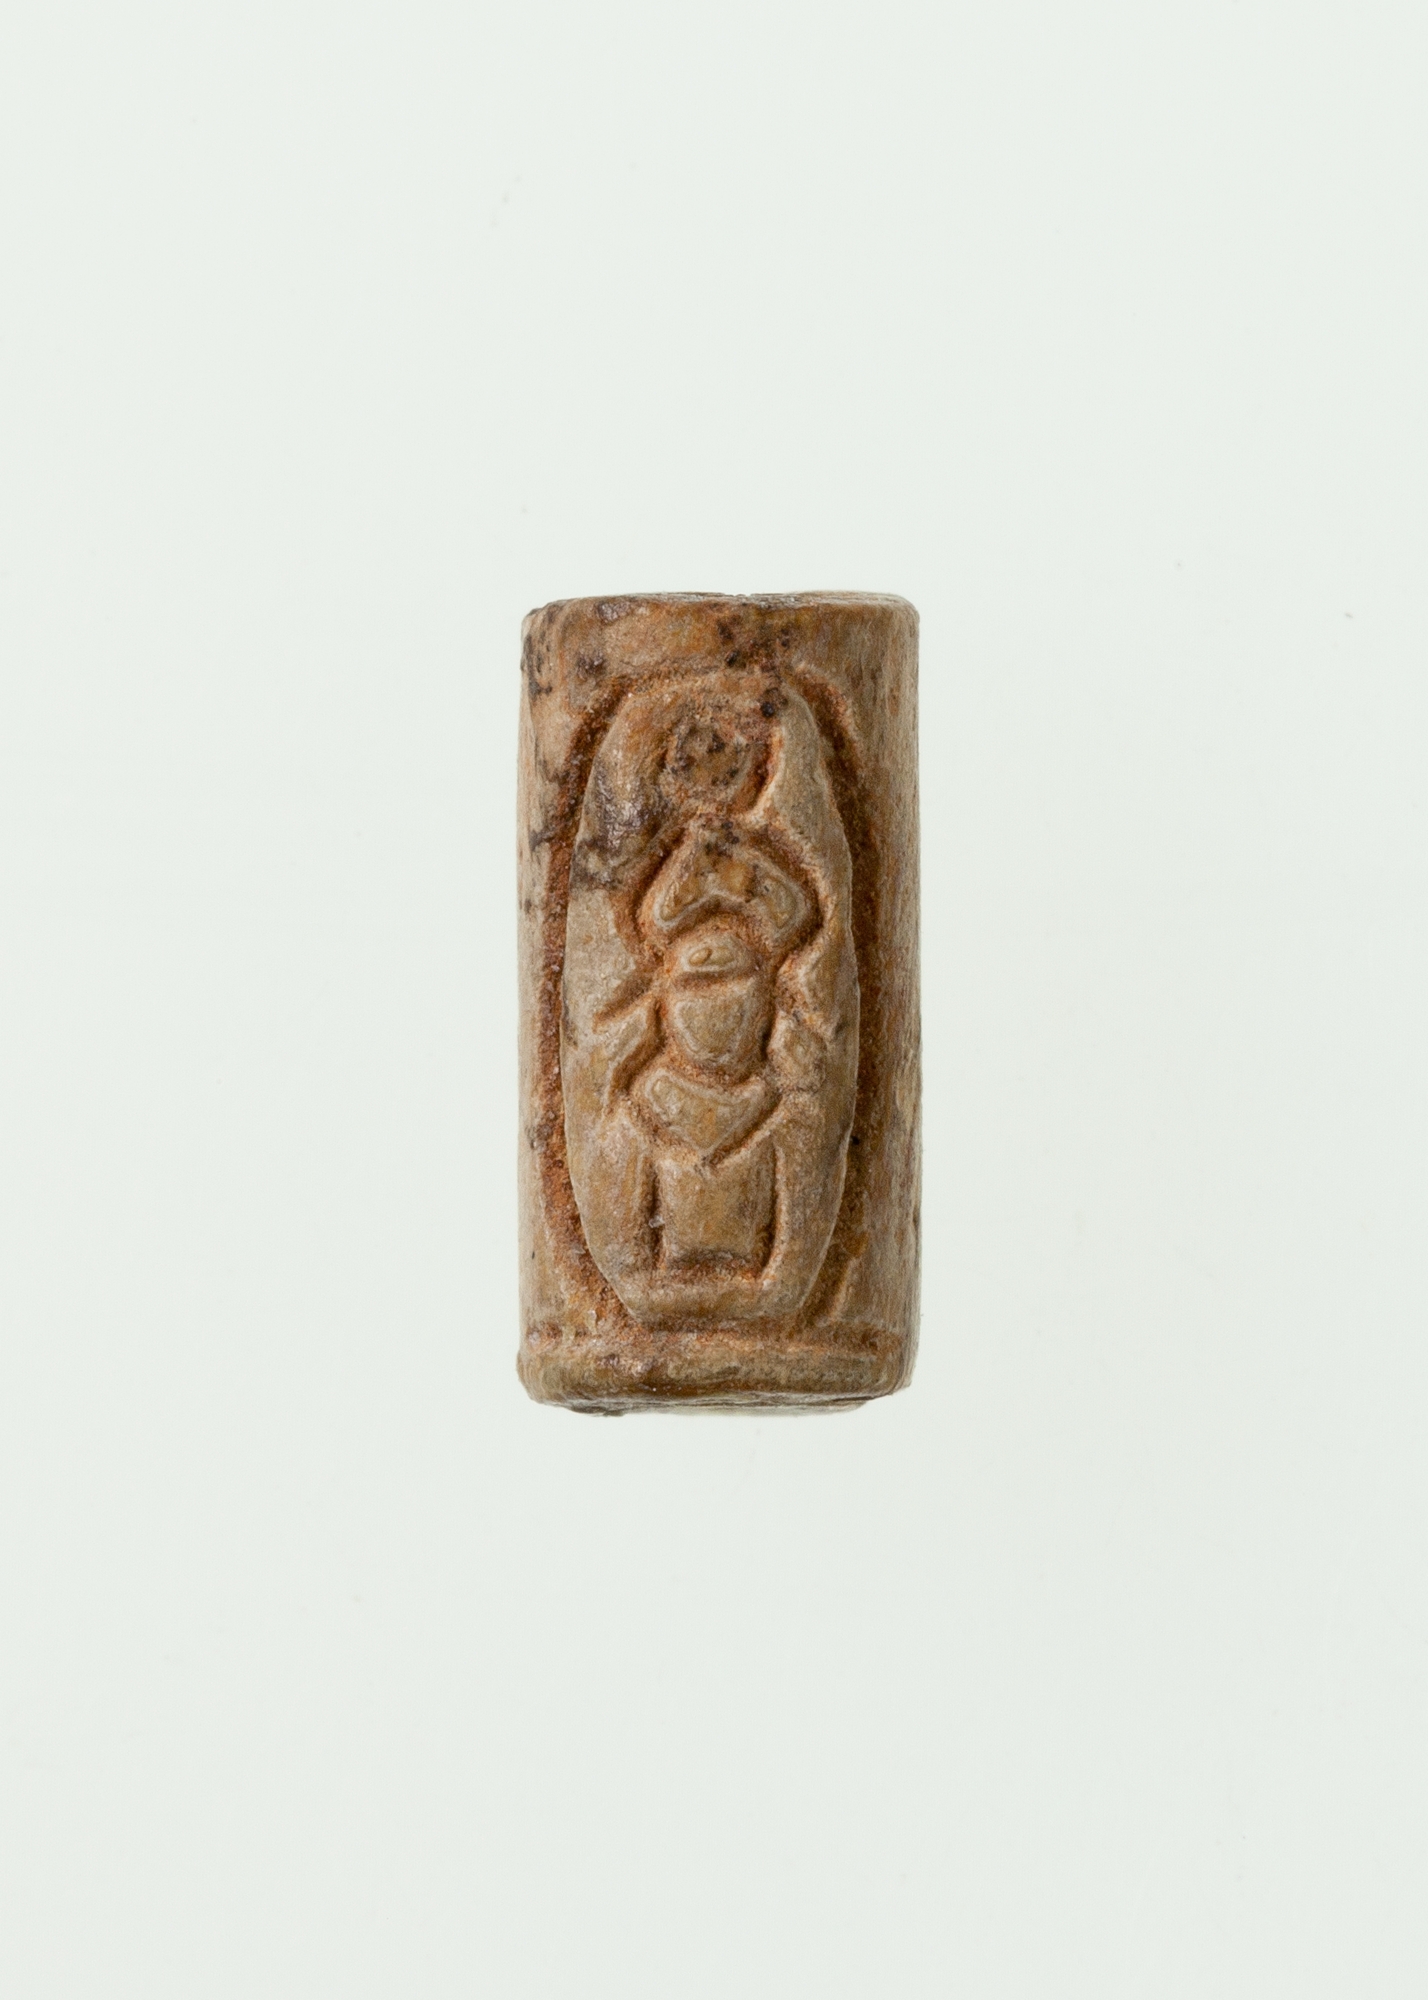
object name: cylinder seal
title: Cylinder seal of Senwosret I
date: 1961-1917 BCE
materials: stone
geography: egypt